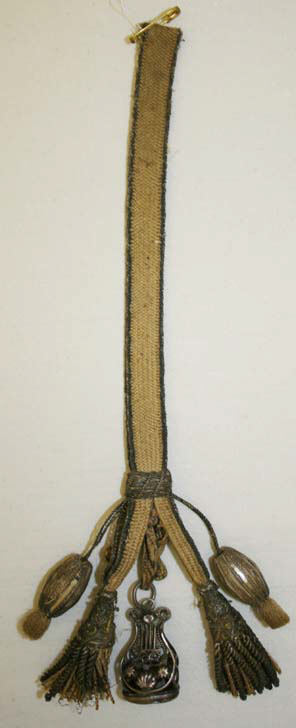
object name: fob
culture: french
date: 1701-1800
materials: metal, silk